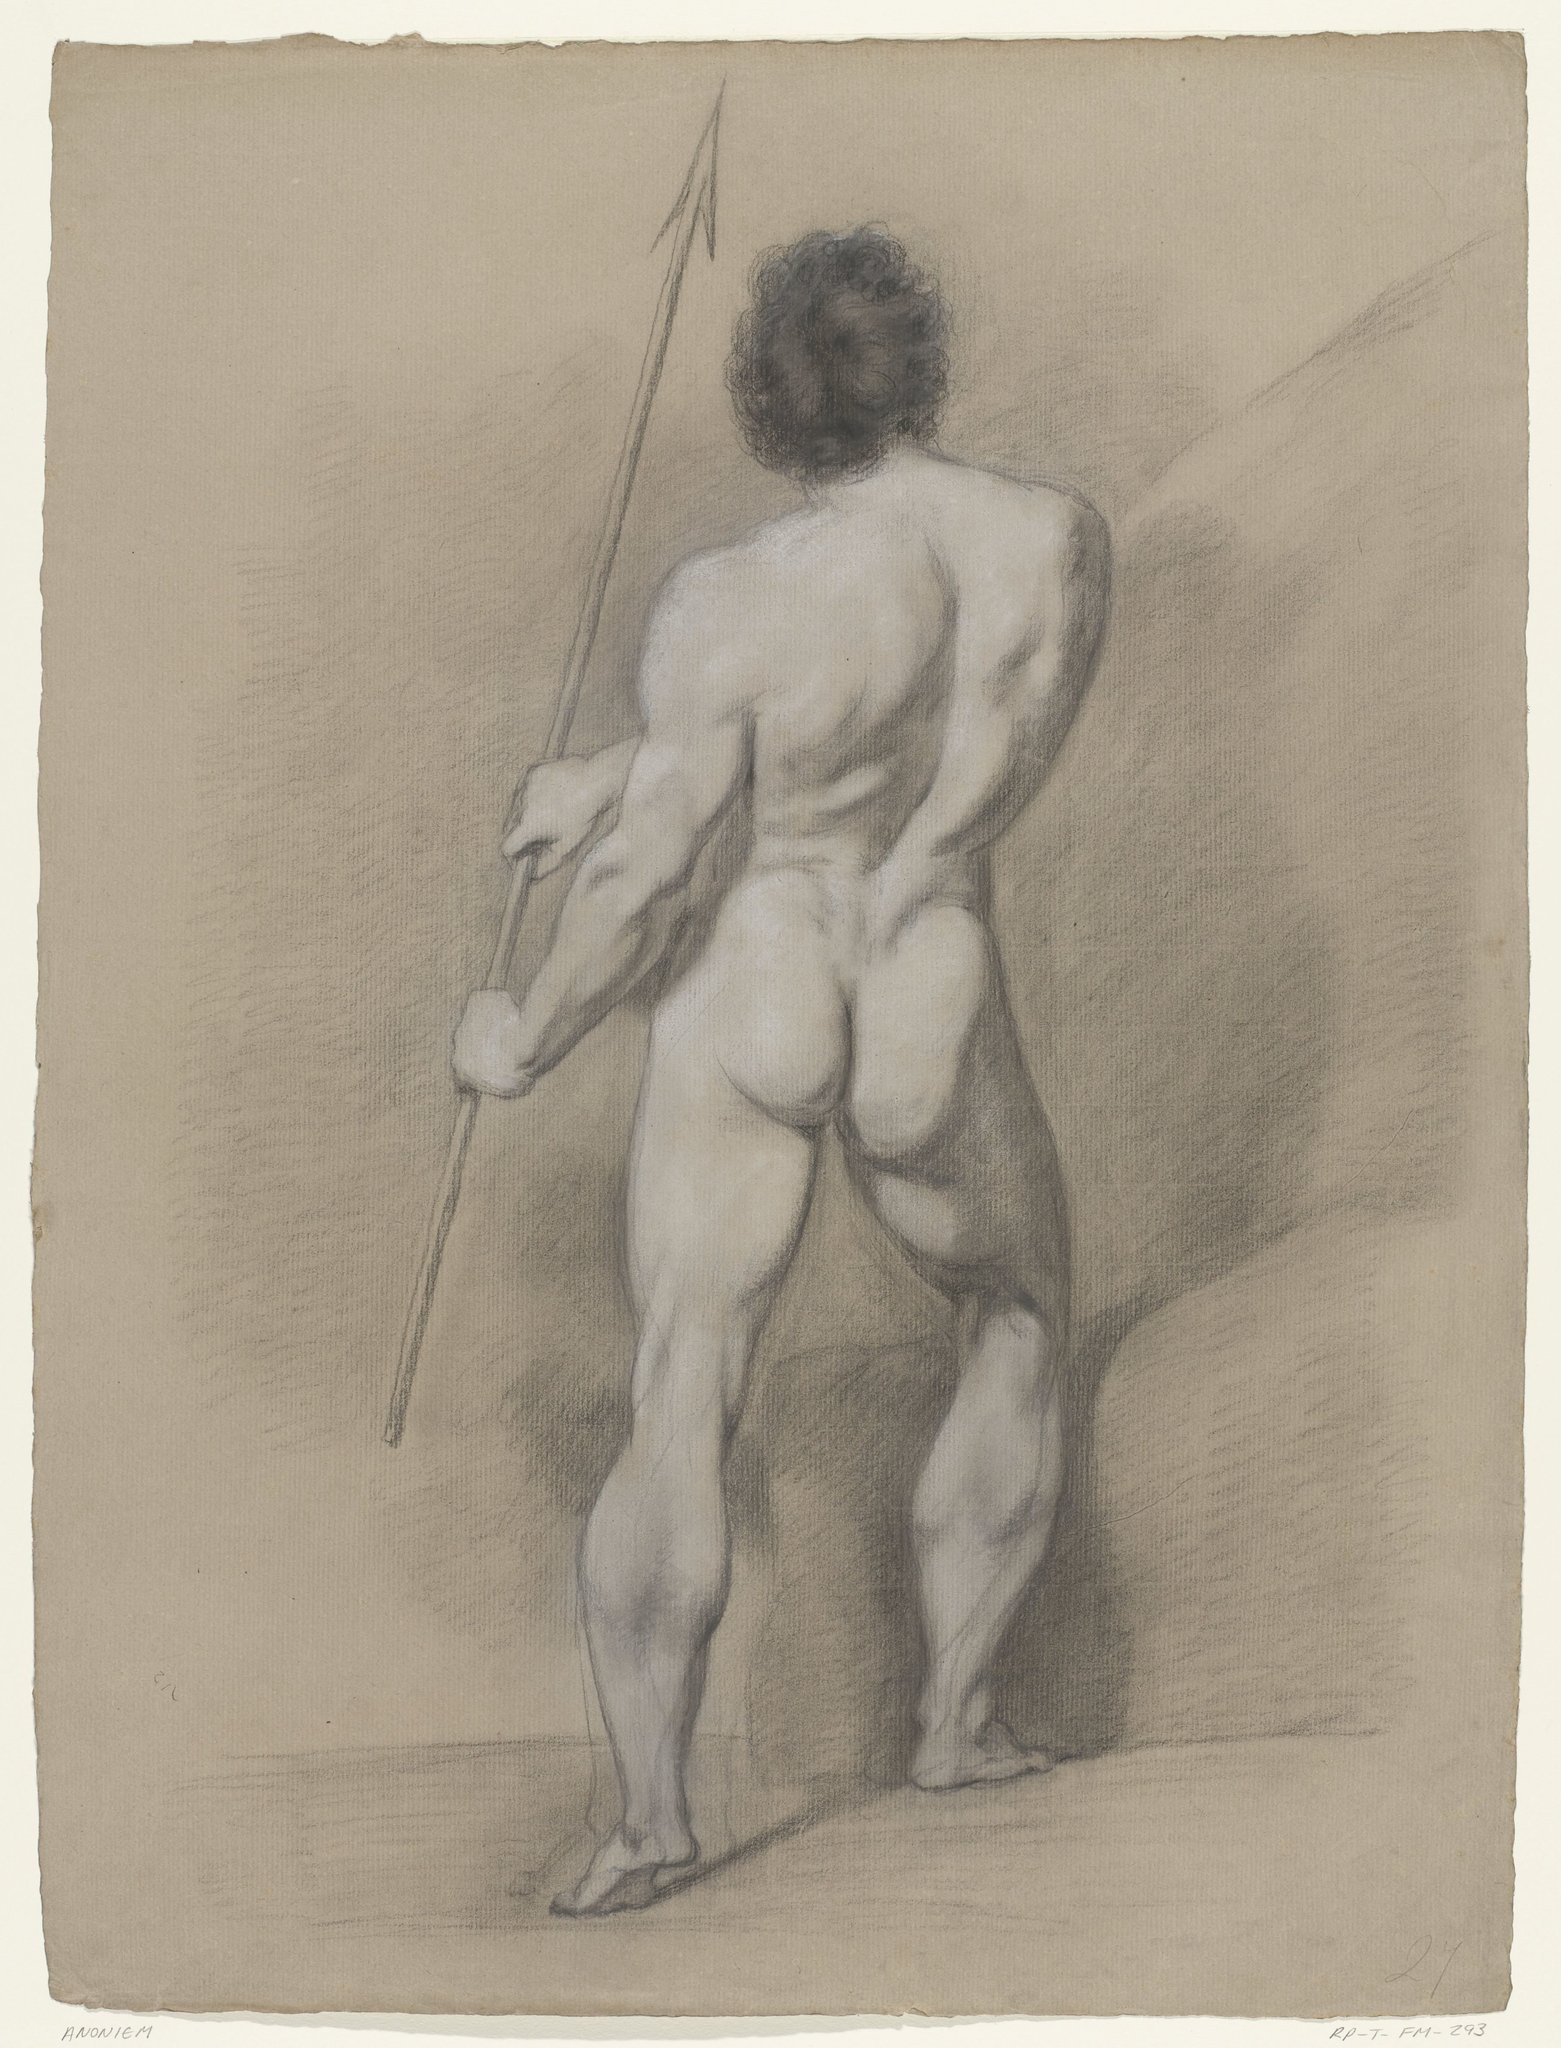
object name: drawing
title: Staand mannelijk naakt met speer, van achteren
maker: Anonymous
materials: chalk, paper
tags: standing figure